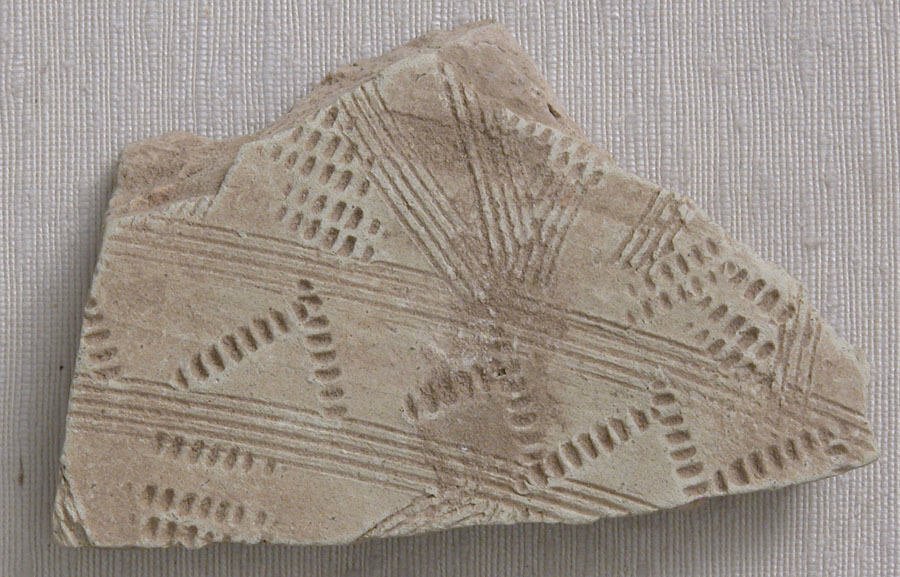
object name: fragment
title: Ceramic Fragment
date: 701-900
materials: earthenware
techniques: incising, stamping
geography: iraq